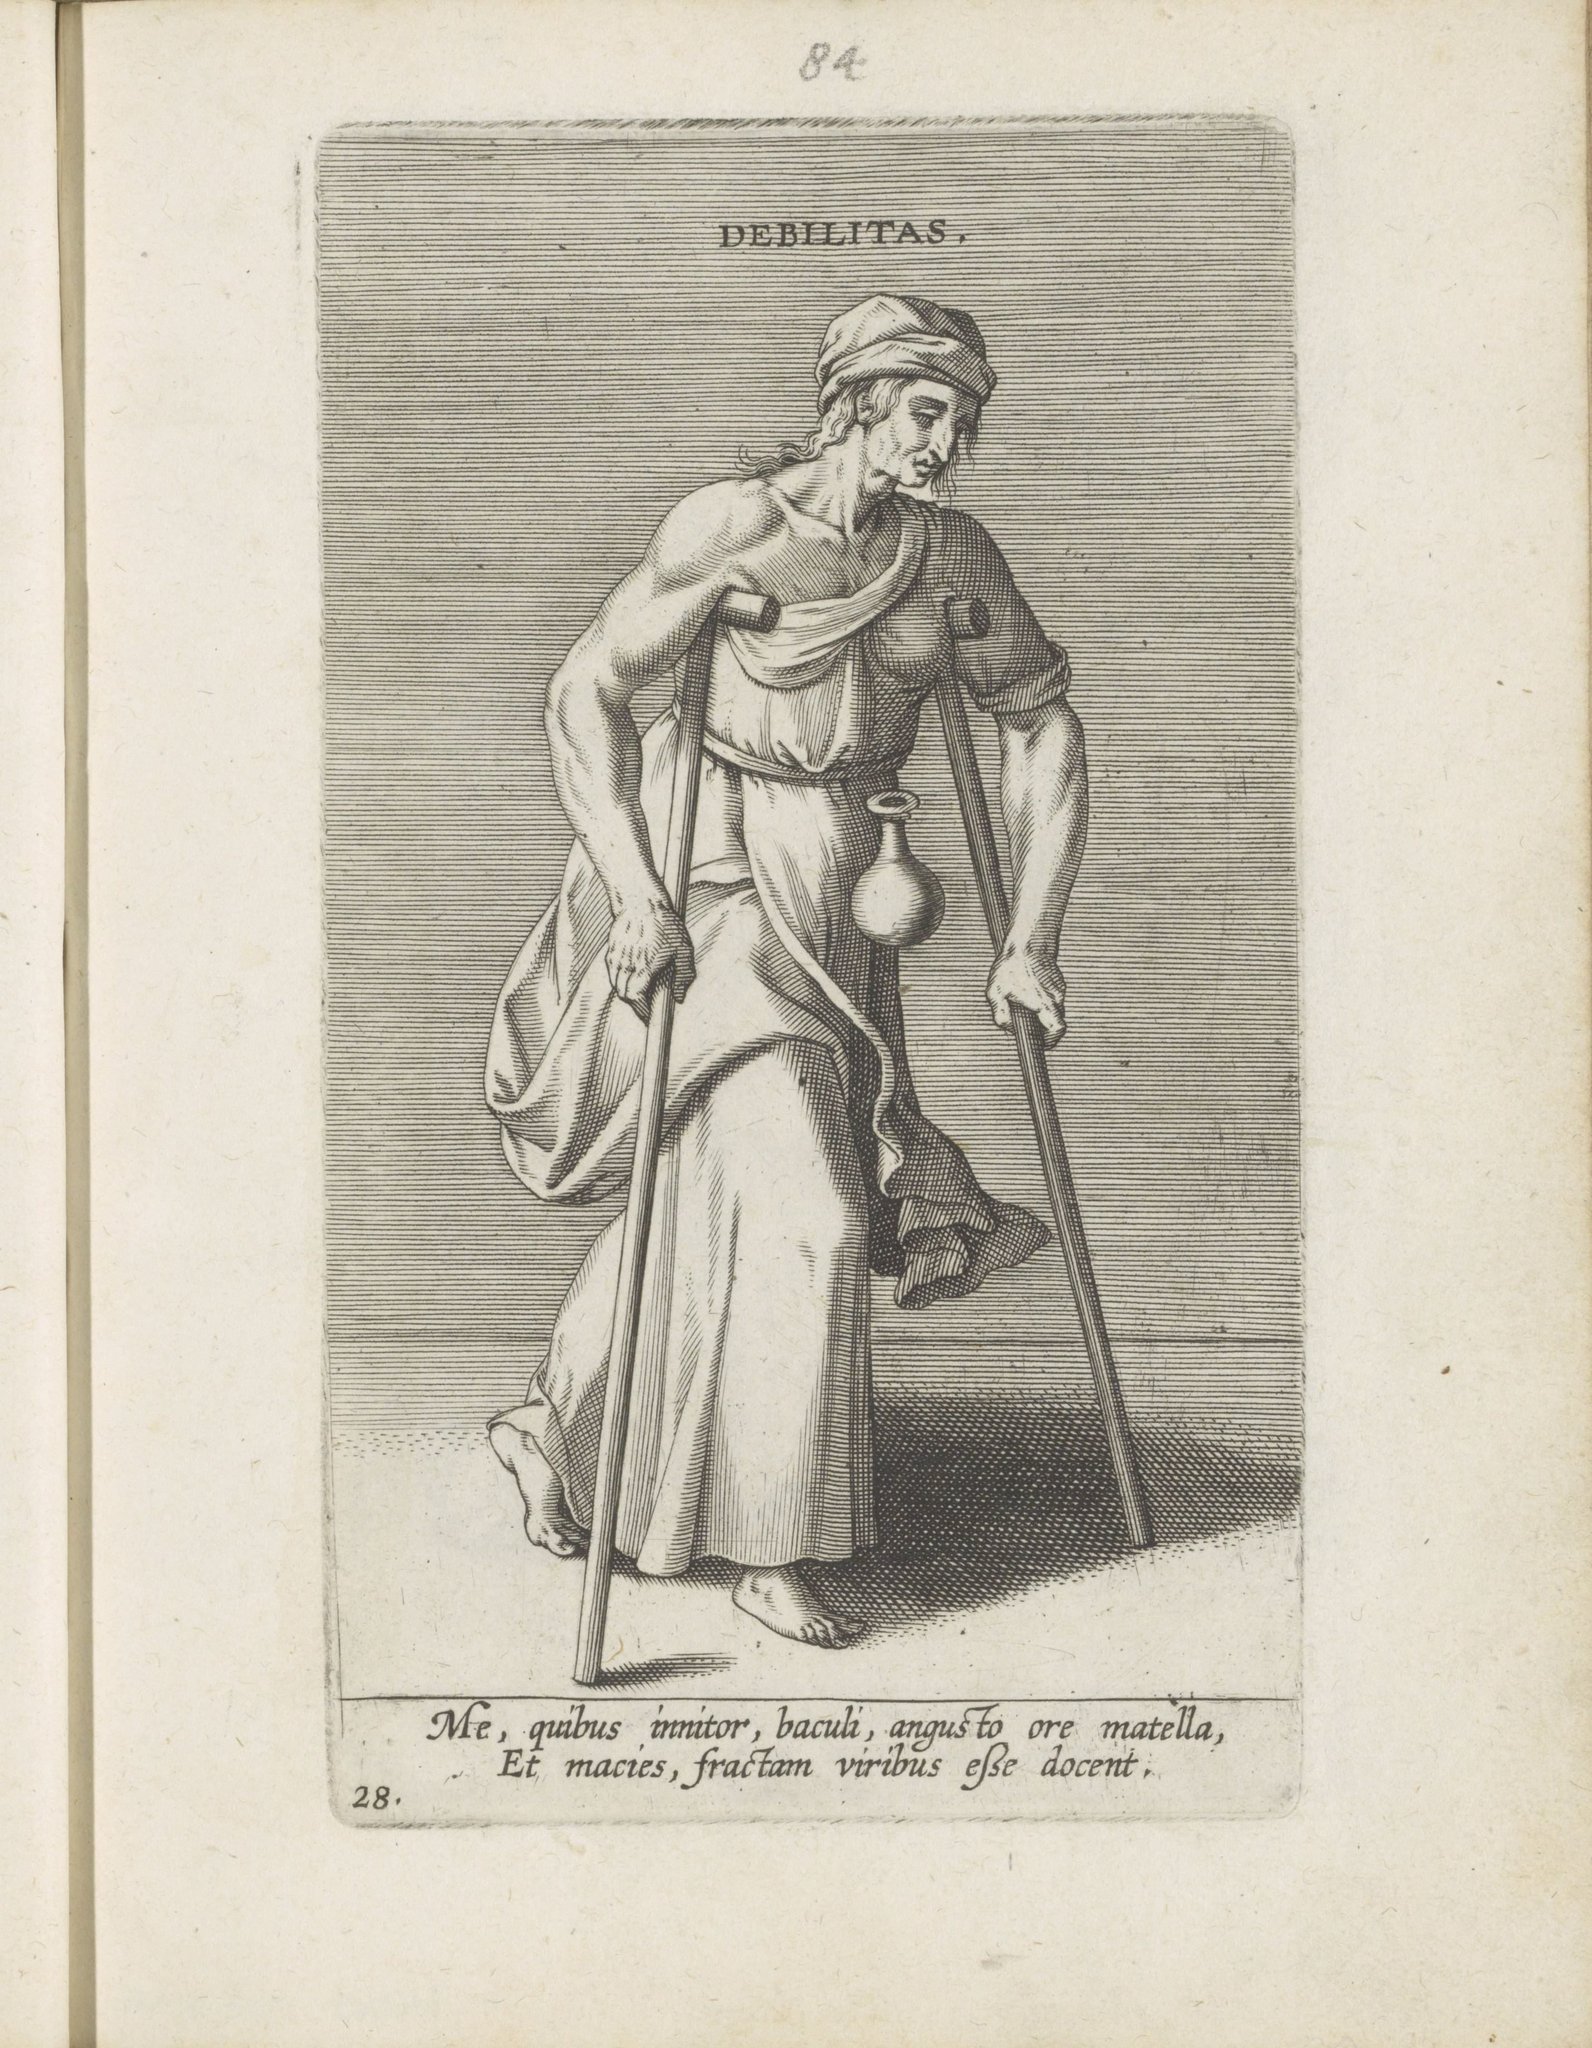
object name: print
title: Prosopographia, sive virtutum, animi, corporis, bonorum externorum, vitiorum, et affectuum variorum delineatio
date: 1585-1590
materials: paper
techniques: engraving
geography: antwerp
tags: crutches - aa - female human figure, disabilities, deformations and monstrosities; diseases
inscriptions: collector's mark: Lugt 2760, collector's mark: Lugt 2228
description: Een uitgemergelde vrouw met een waterkruik aan de riem, loopt blootvoets en ondersteund door krukken. Onder de voorstelling twee regels tekst in het Latijn. De prent maakt deel uit van een album.